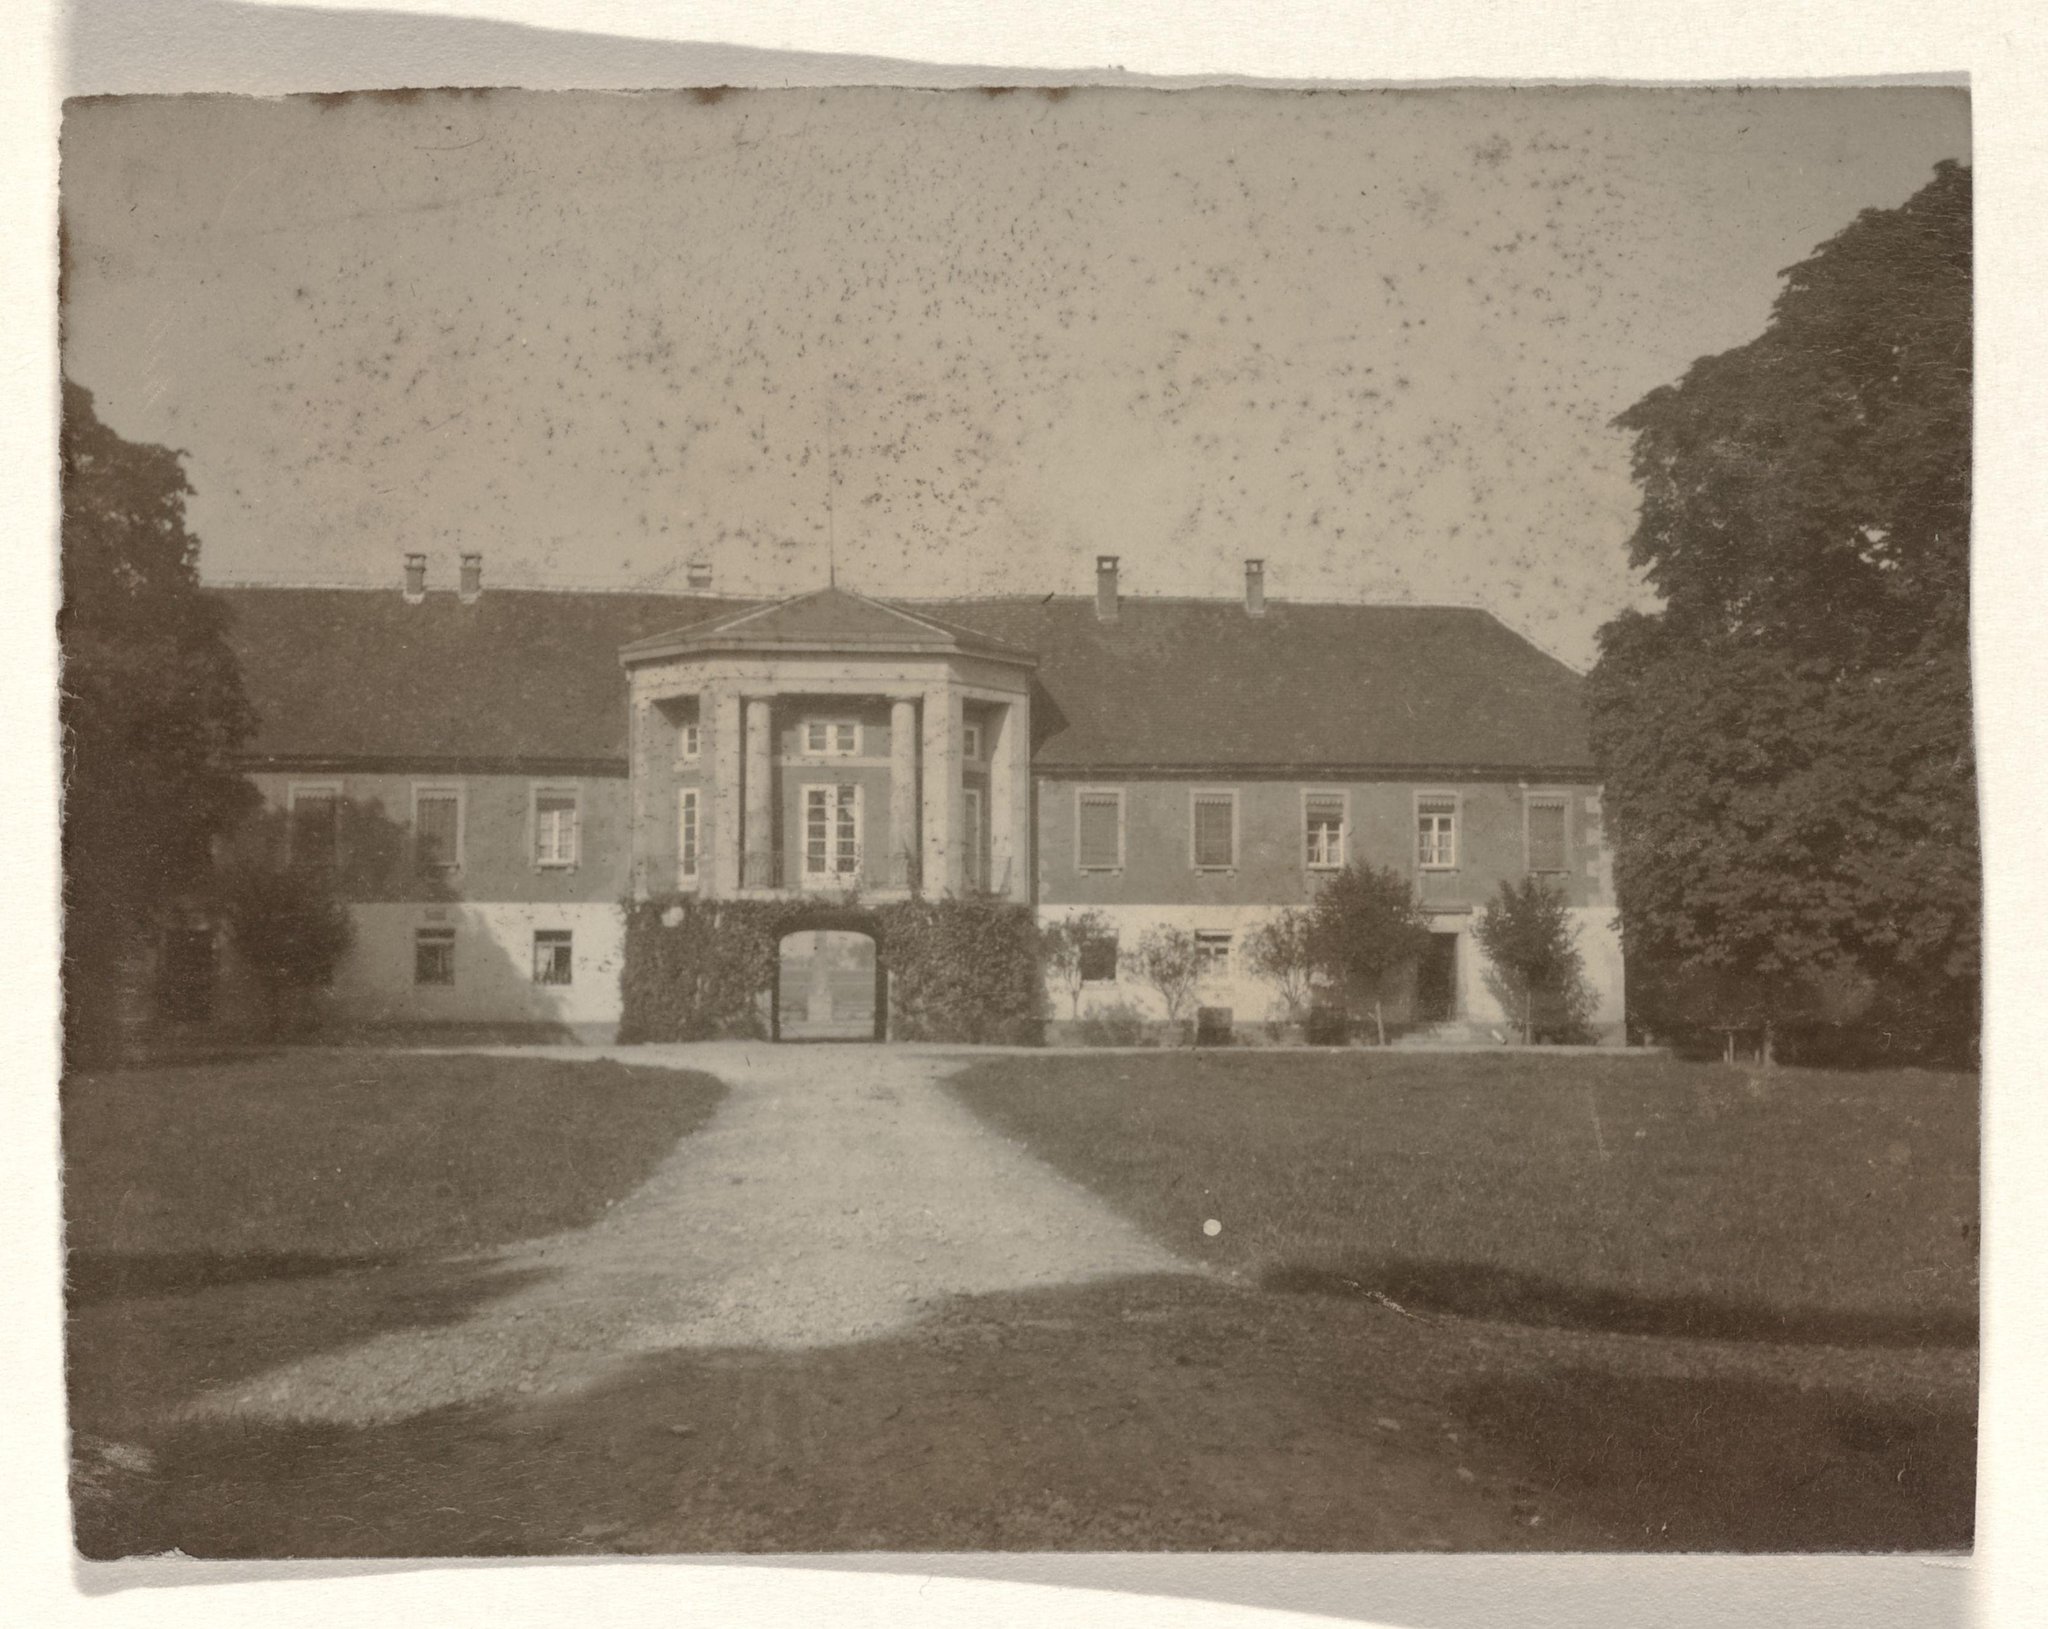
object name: photograph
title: Vooraanzicht van een landhuis met prieelvormig middenstuk, met bomen aan weerszijden en een gazon en oprijlaan aan de voorkant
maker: Anonymous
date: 1900-1950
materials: photographic support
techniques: gelatin silver print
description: Vooraanzicht van een landhuis met prieelvormig middenstuk, met bomen aan weerszijden en een gazon en oprijlaan aan de voorkant.